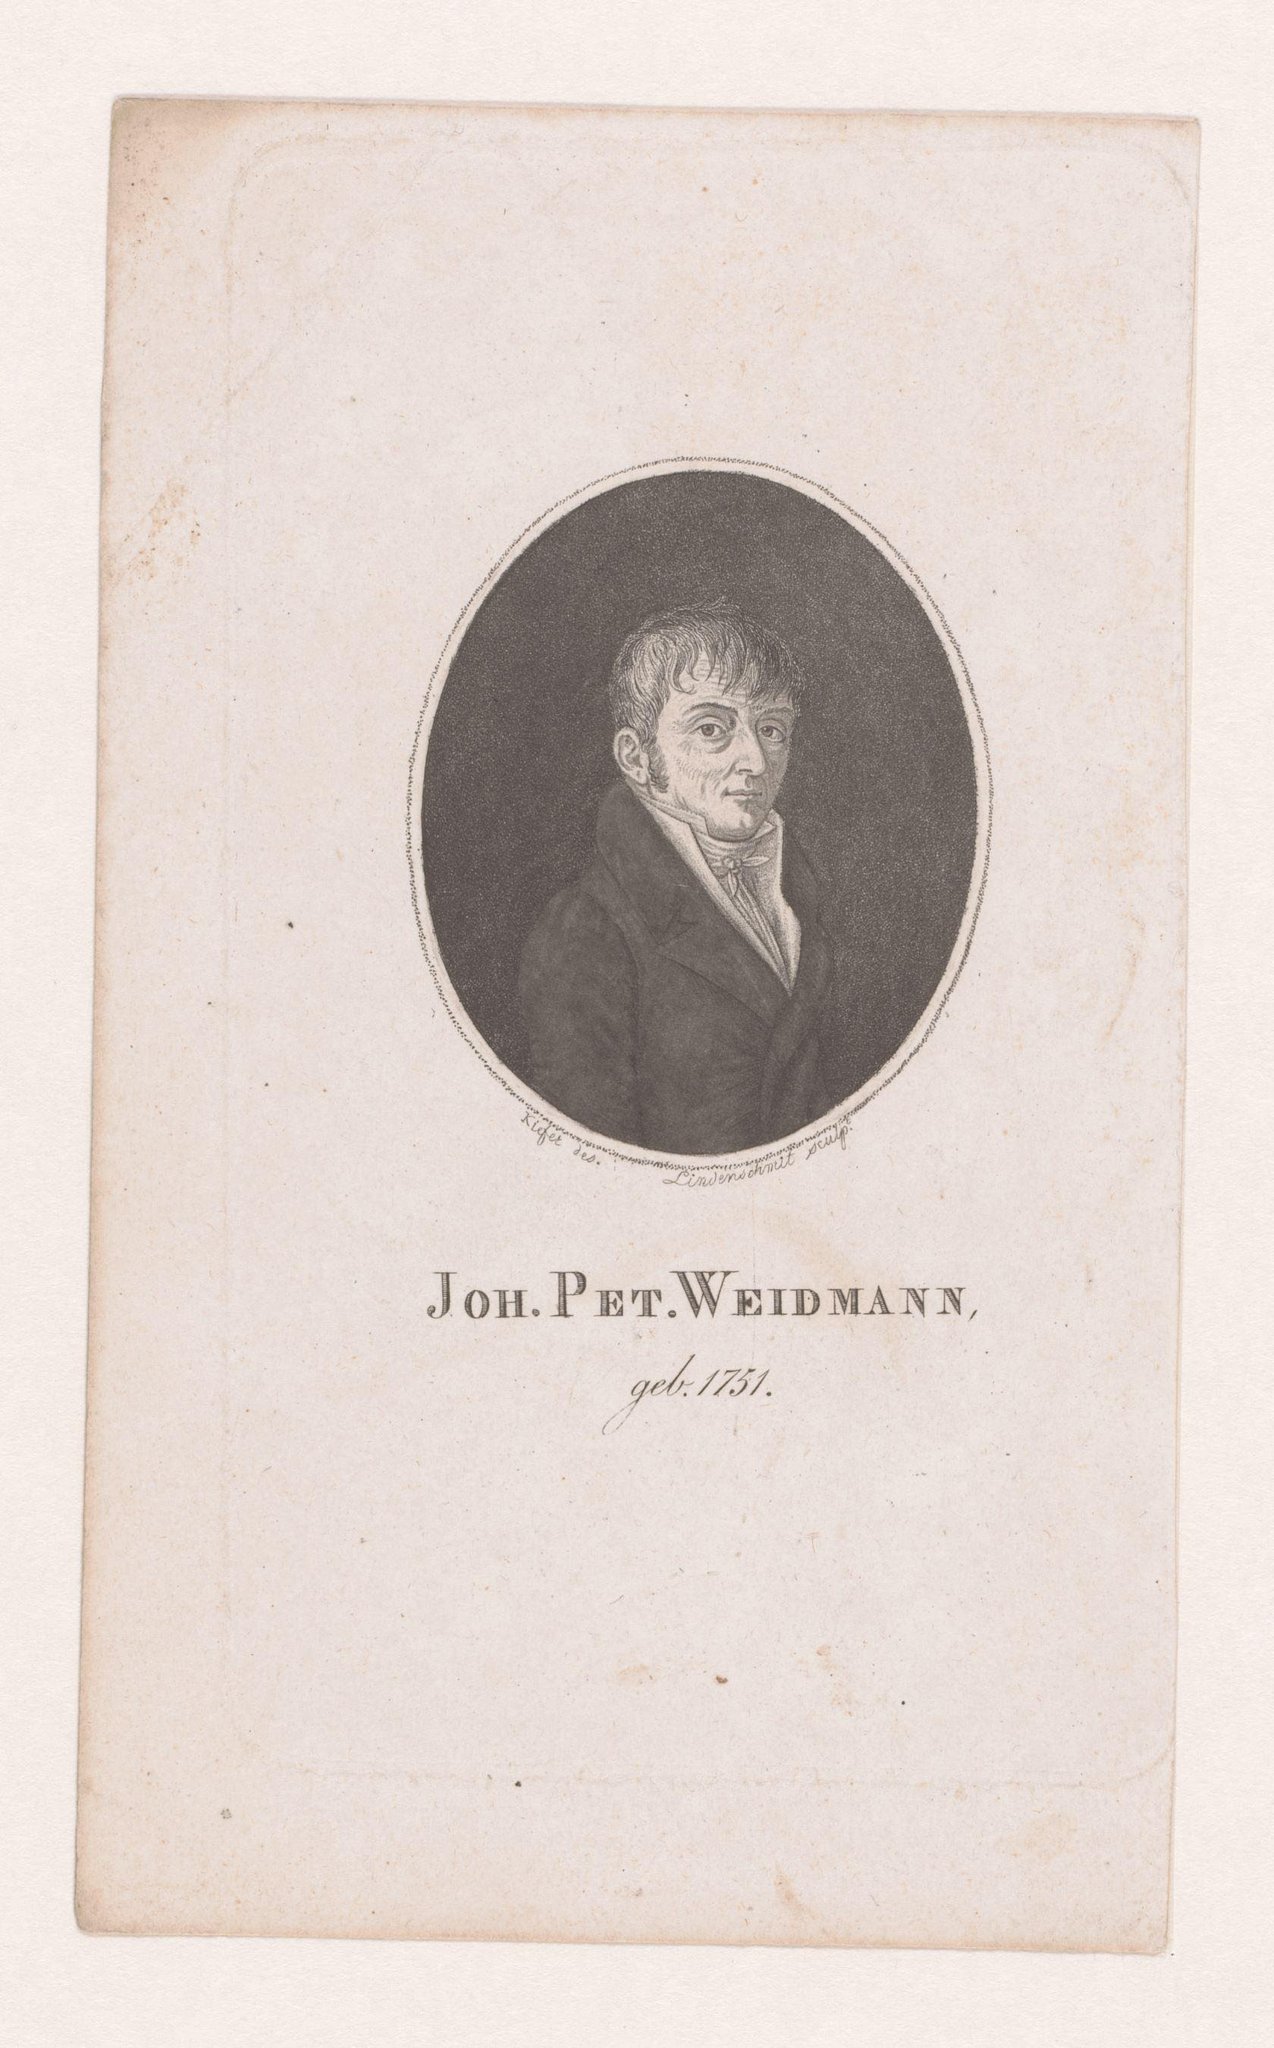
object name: print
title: Portret van Johann Peter Weidmann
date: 1780-1835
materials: paper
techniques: aquatint, etching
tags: historical persons, physician, doctor (+ portrait of scholar, scientist)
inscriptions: collector's mark: Lugt 2228